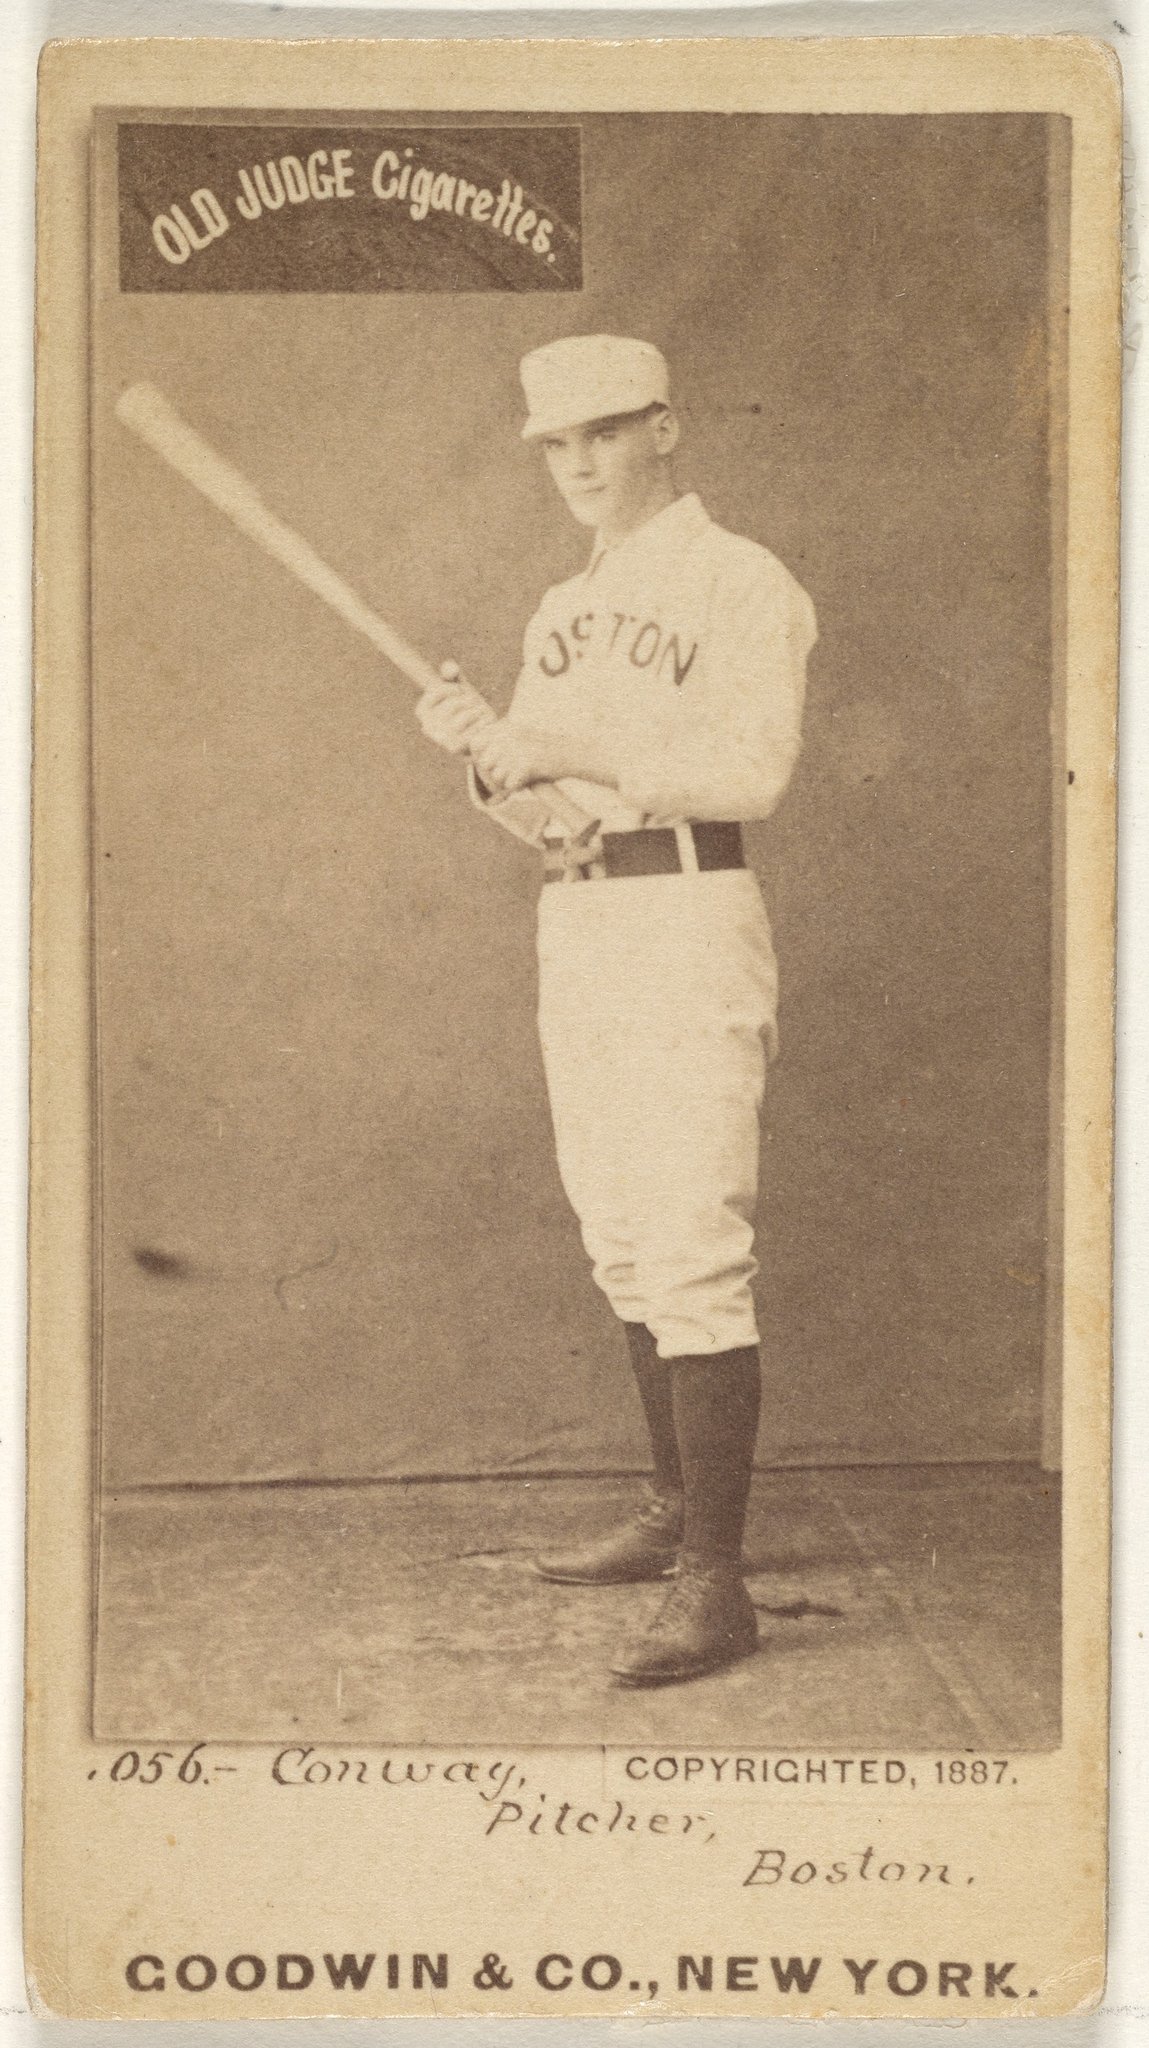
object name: baseball card, photograph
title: Conway, Pitcher, Boston, from the Old Judge series (N172) for Old Judge Cigarettes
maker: goodwin & company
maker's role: publisher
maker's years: 1850-1950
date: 1887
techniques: albumen silver print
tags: men,portraits,baseball,athletes